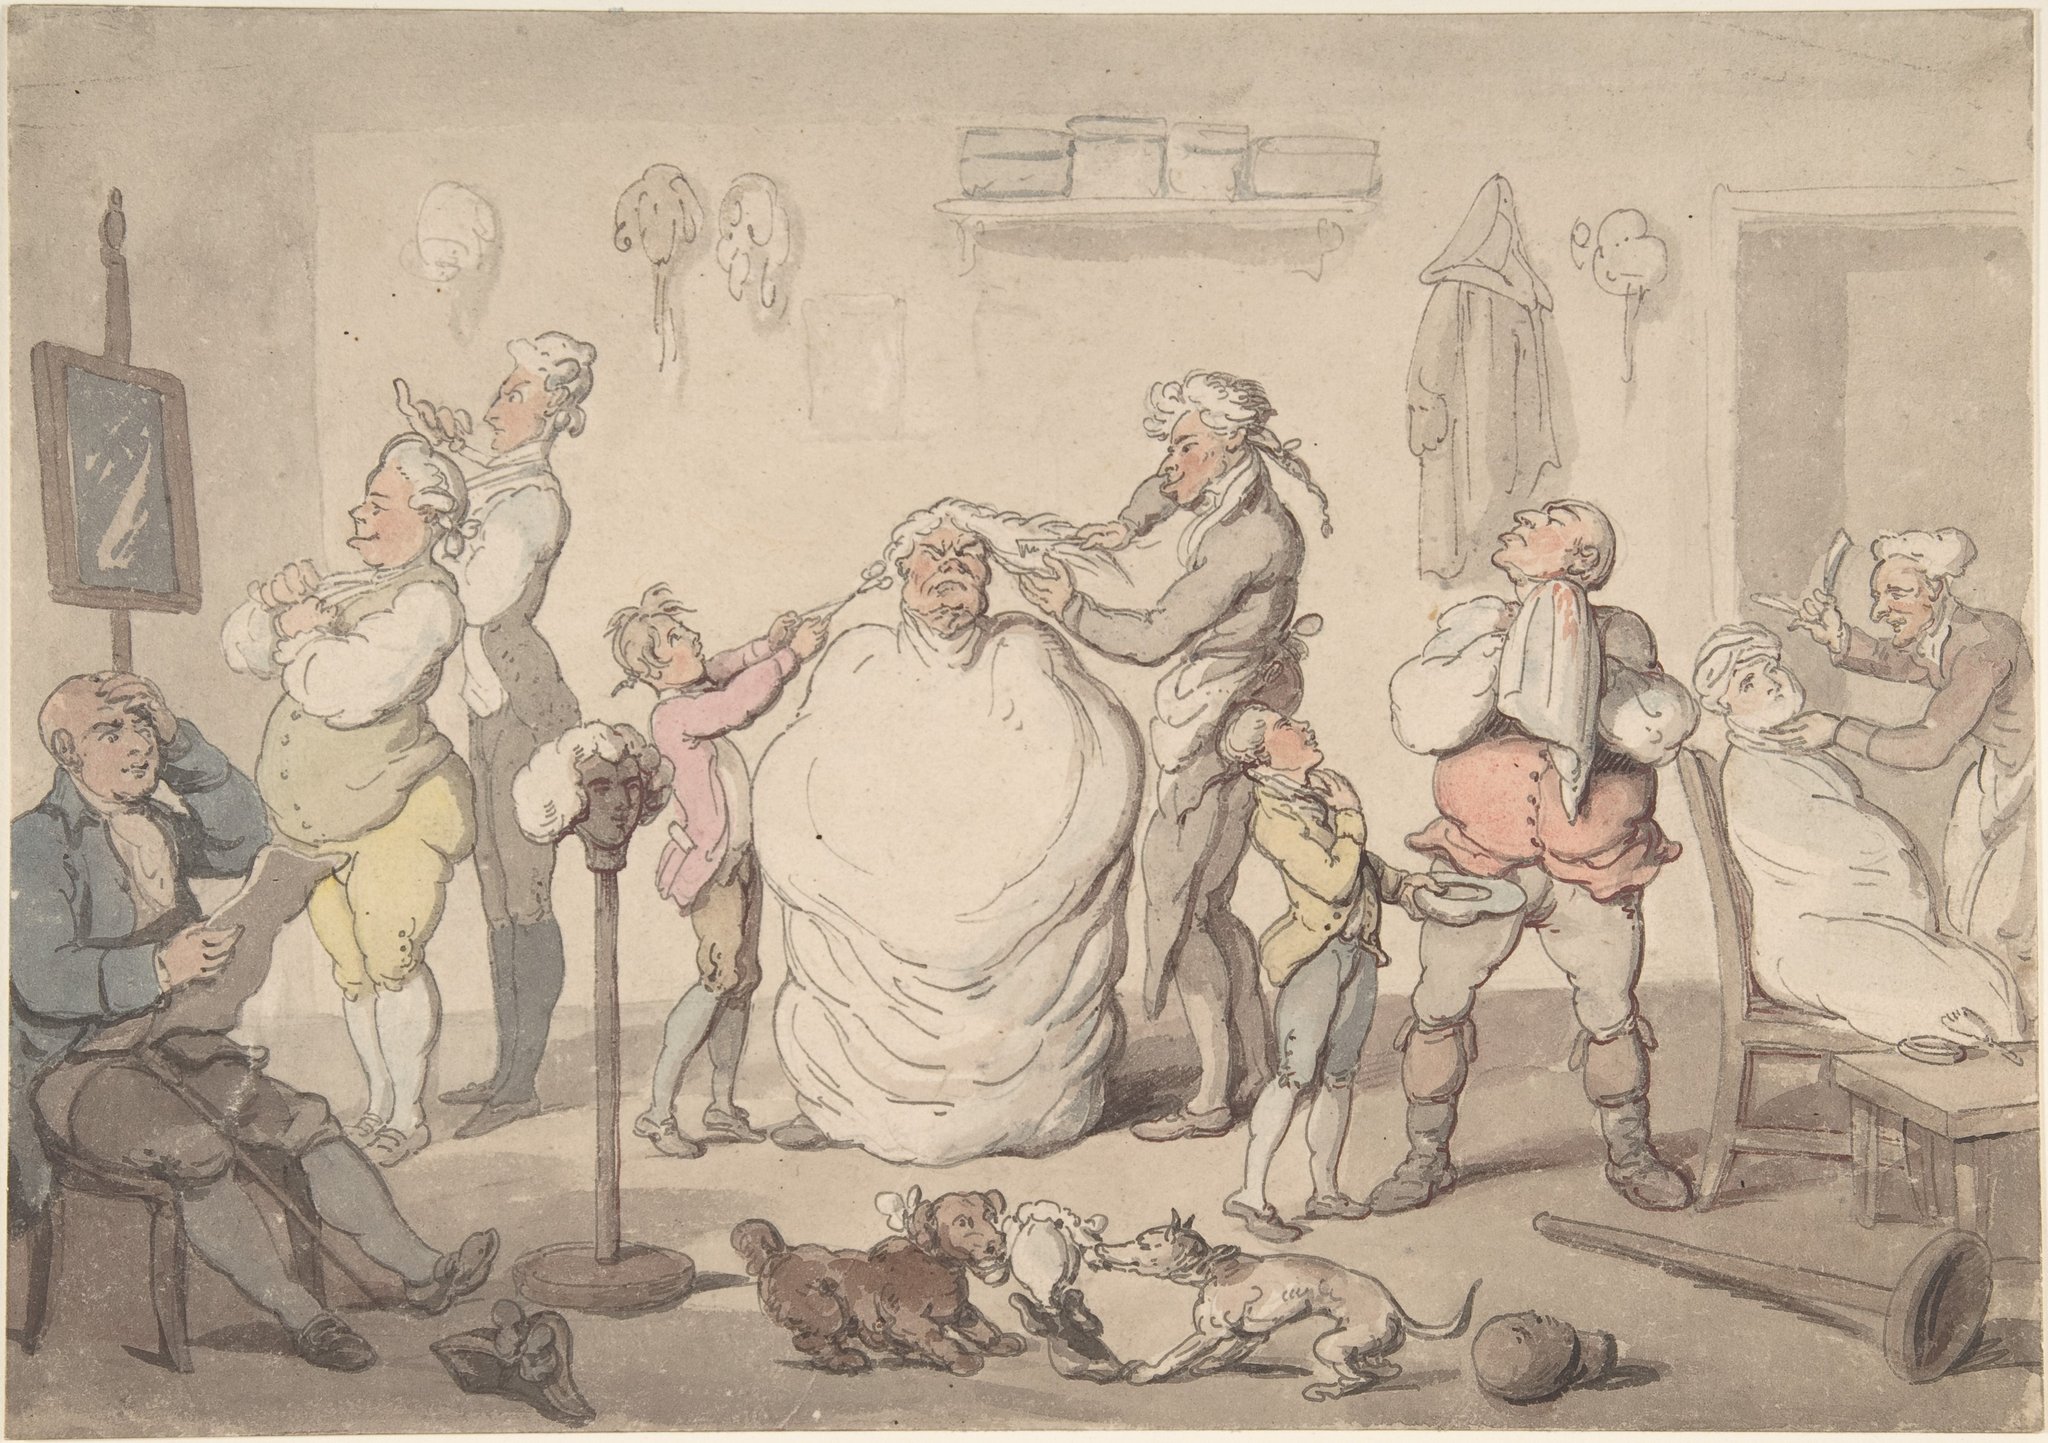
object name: drawing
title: The Barber's Shop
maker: thomas rowlandson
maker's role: artist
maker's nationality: british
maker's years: 1757-1827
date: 1785-1805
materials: ink, watercolor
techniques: pen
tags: satire,men,dogs,barbers